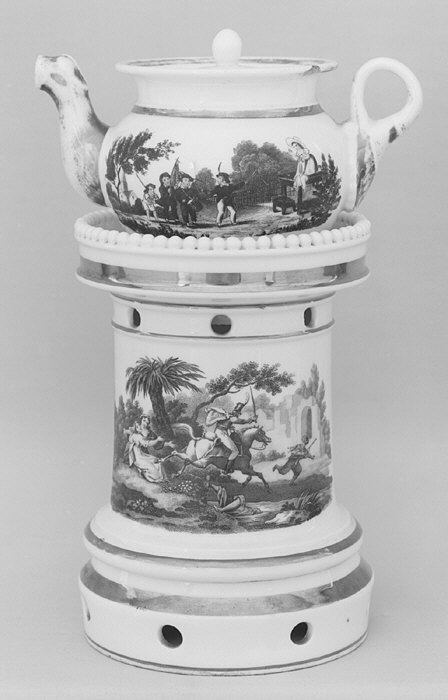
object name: tea warmer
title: Tea warmer (veilleuse)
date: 1830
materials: hard paste porcelain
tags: men,women,horses,trees